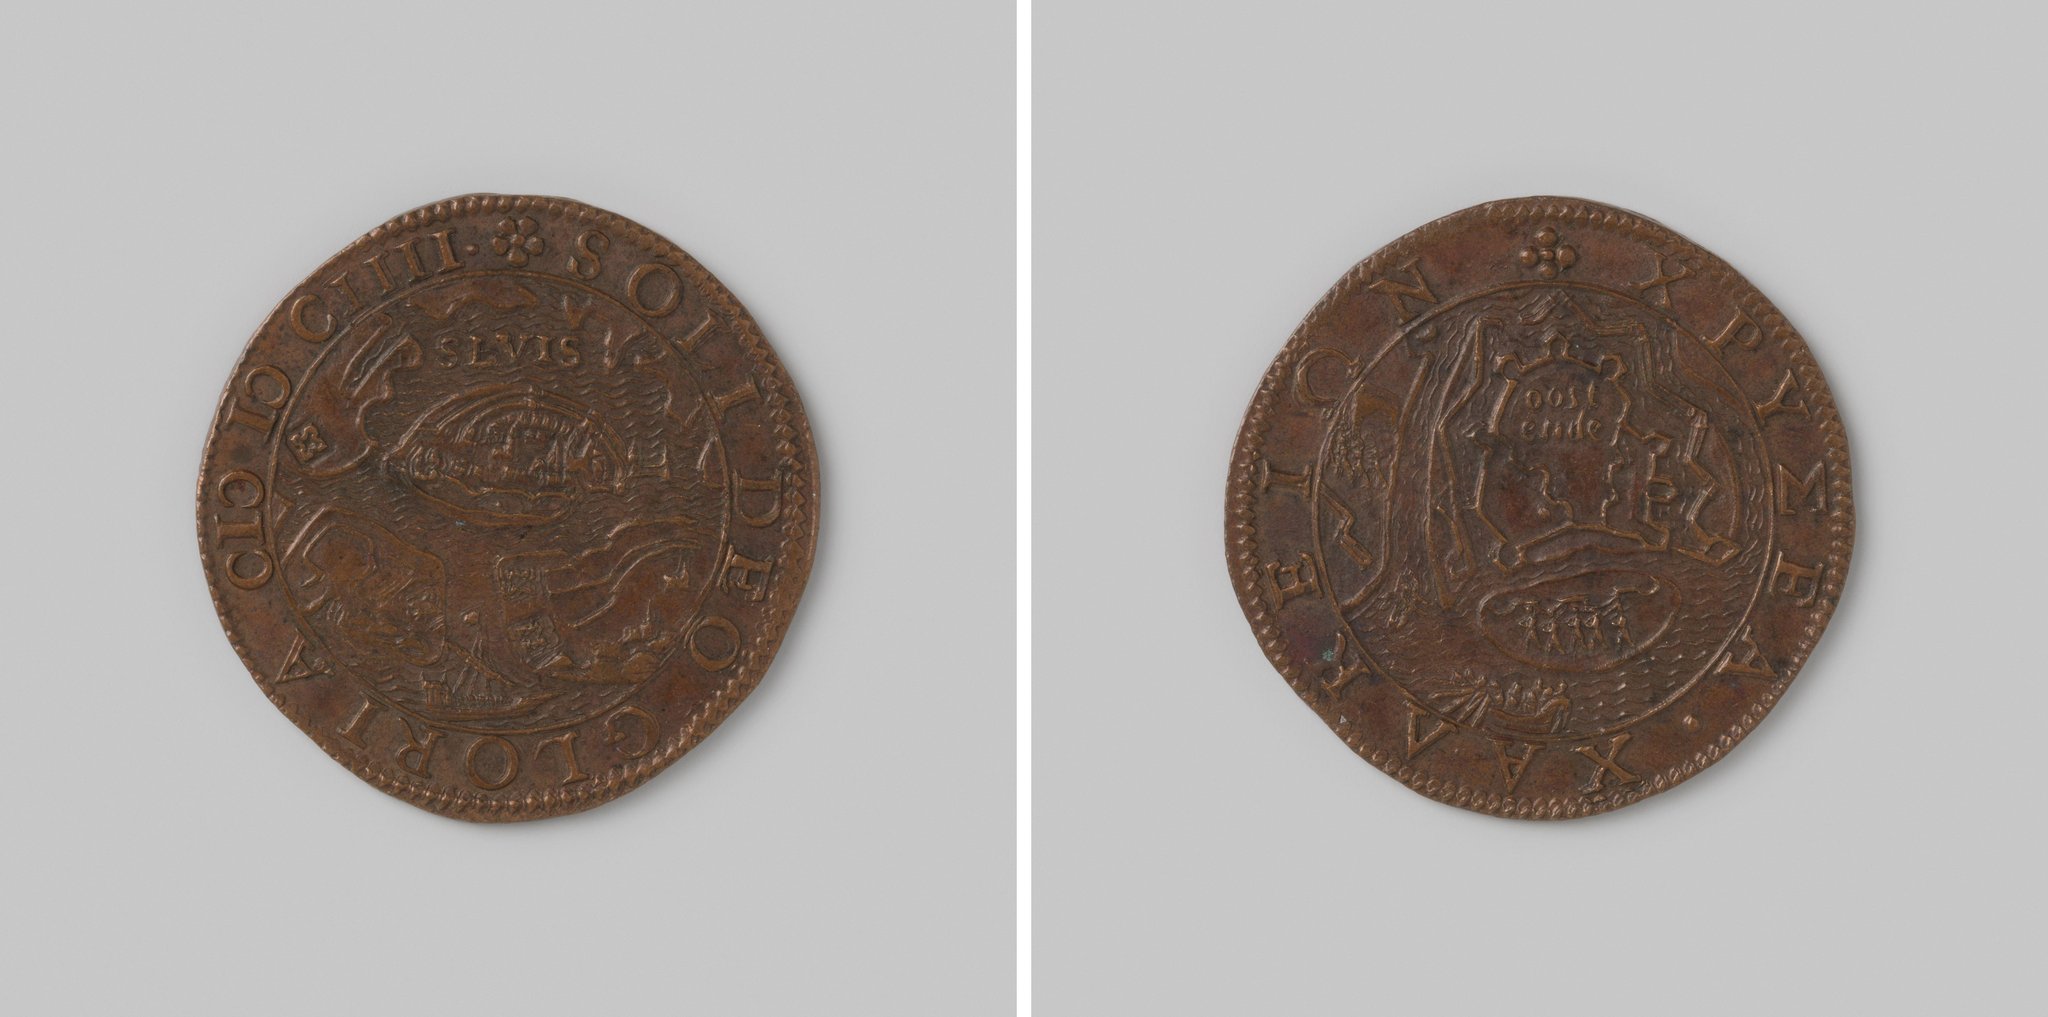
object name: history medal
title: Rekenpenning uit Dordrecht op de overgave van Ostende 1604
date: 1604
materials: copper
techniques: striking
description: Koperen penning, op de voorzijde de plattegrond van Sluis en omgeving, met omschrift, op de keerzijde de plattegrond van Ostende, met omschrift.